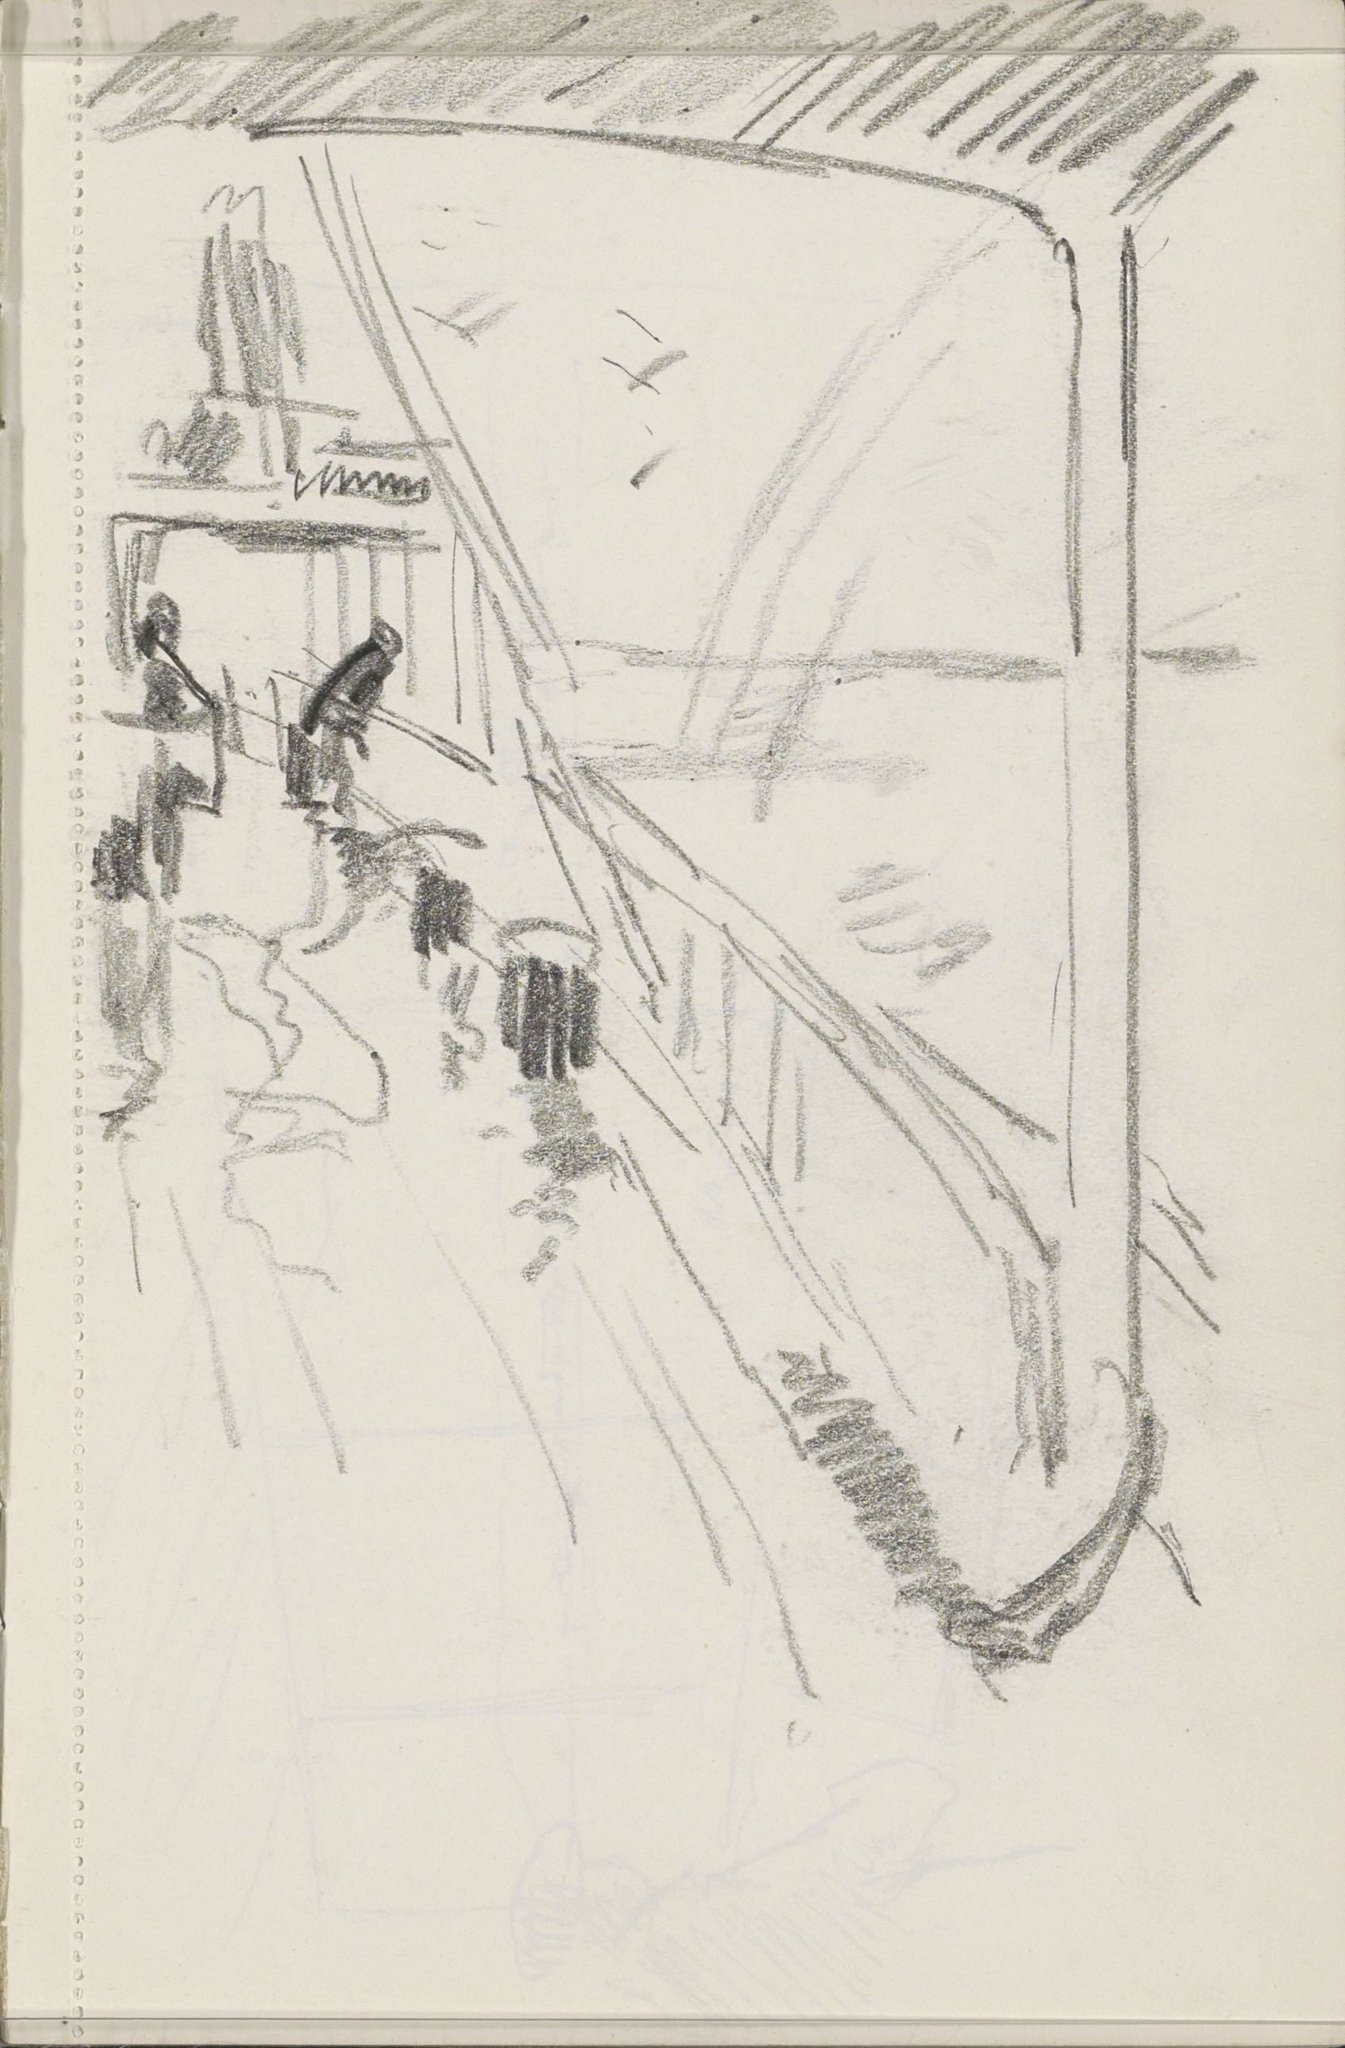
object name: sketchbook leaf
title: Figuren op het dek van een schip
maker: cornelis vreedenburgh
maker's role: draughtsman, print maker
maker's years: 1880-1946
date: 1936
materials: chalk, paper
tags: parts of ship's exterior: deck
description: Blad 18 recto uit een schetsboek met 73 bladen.